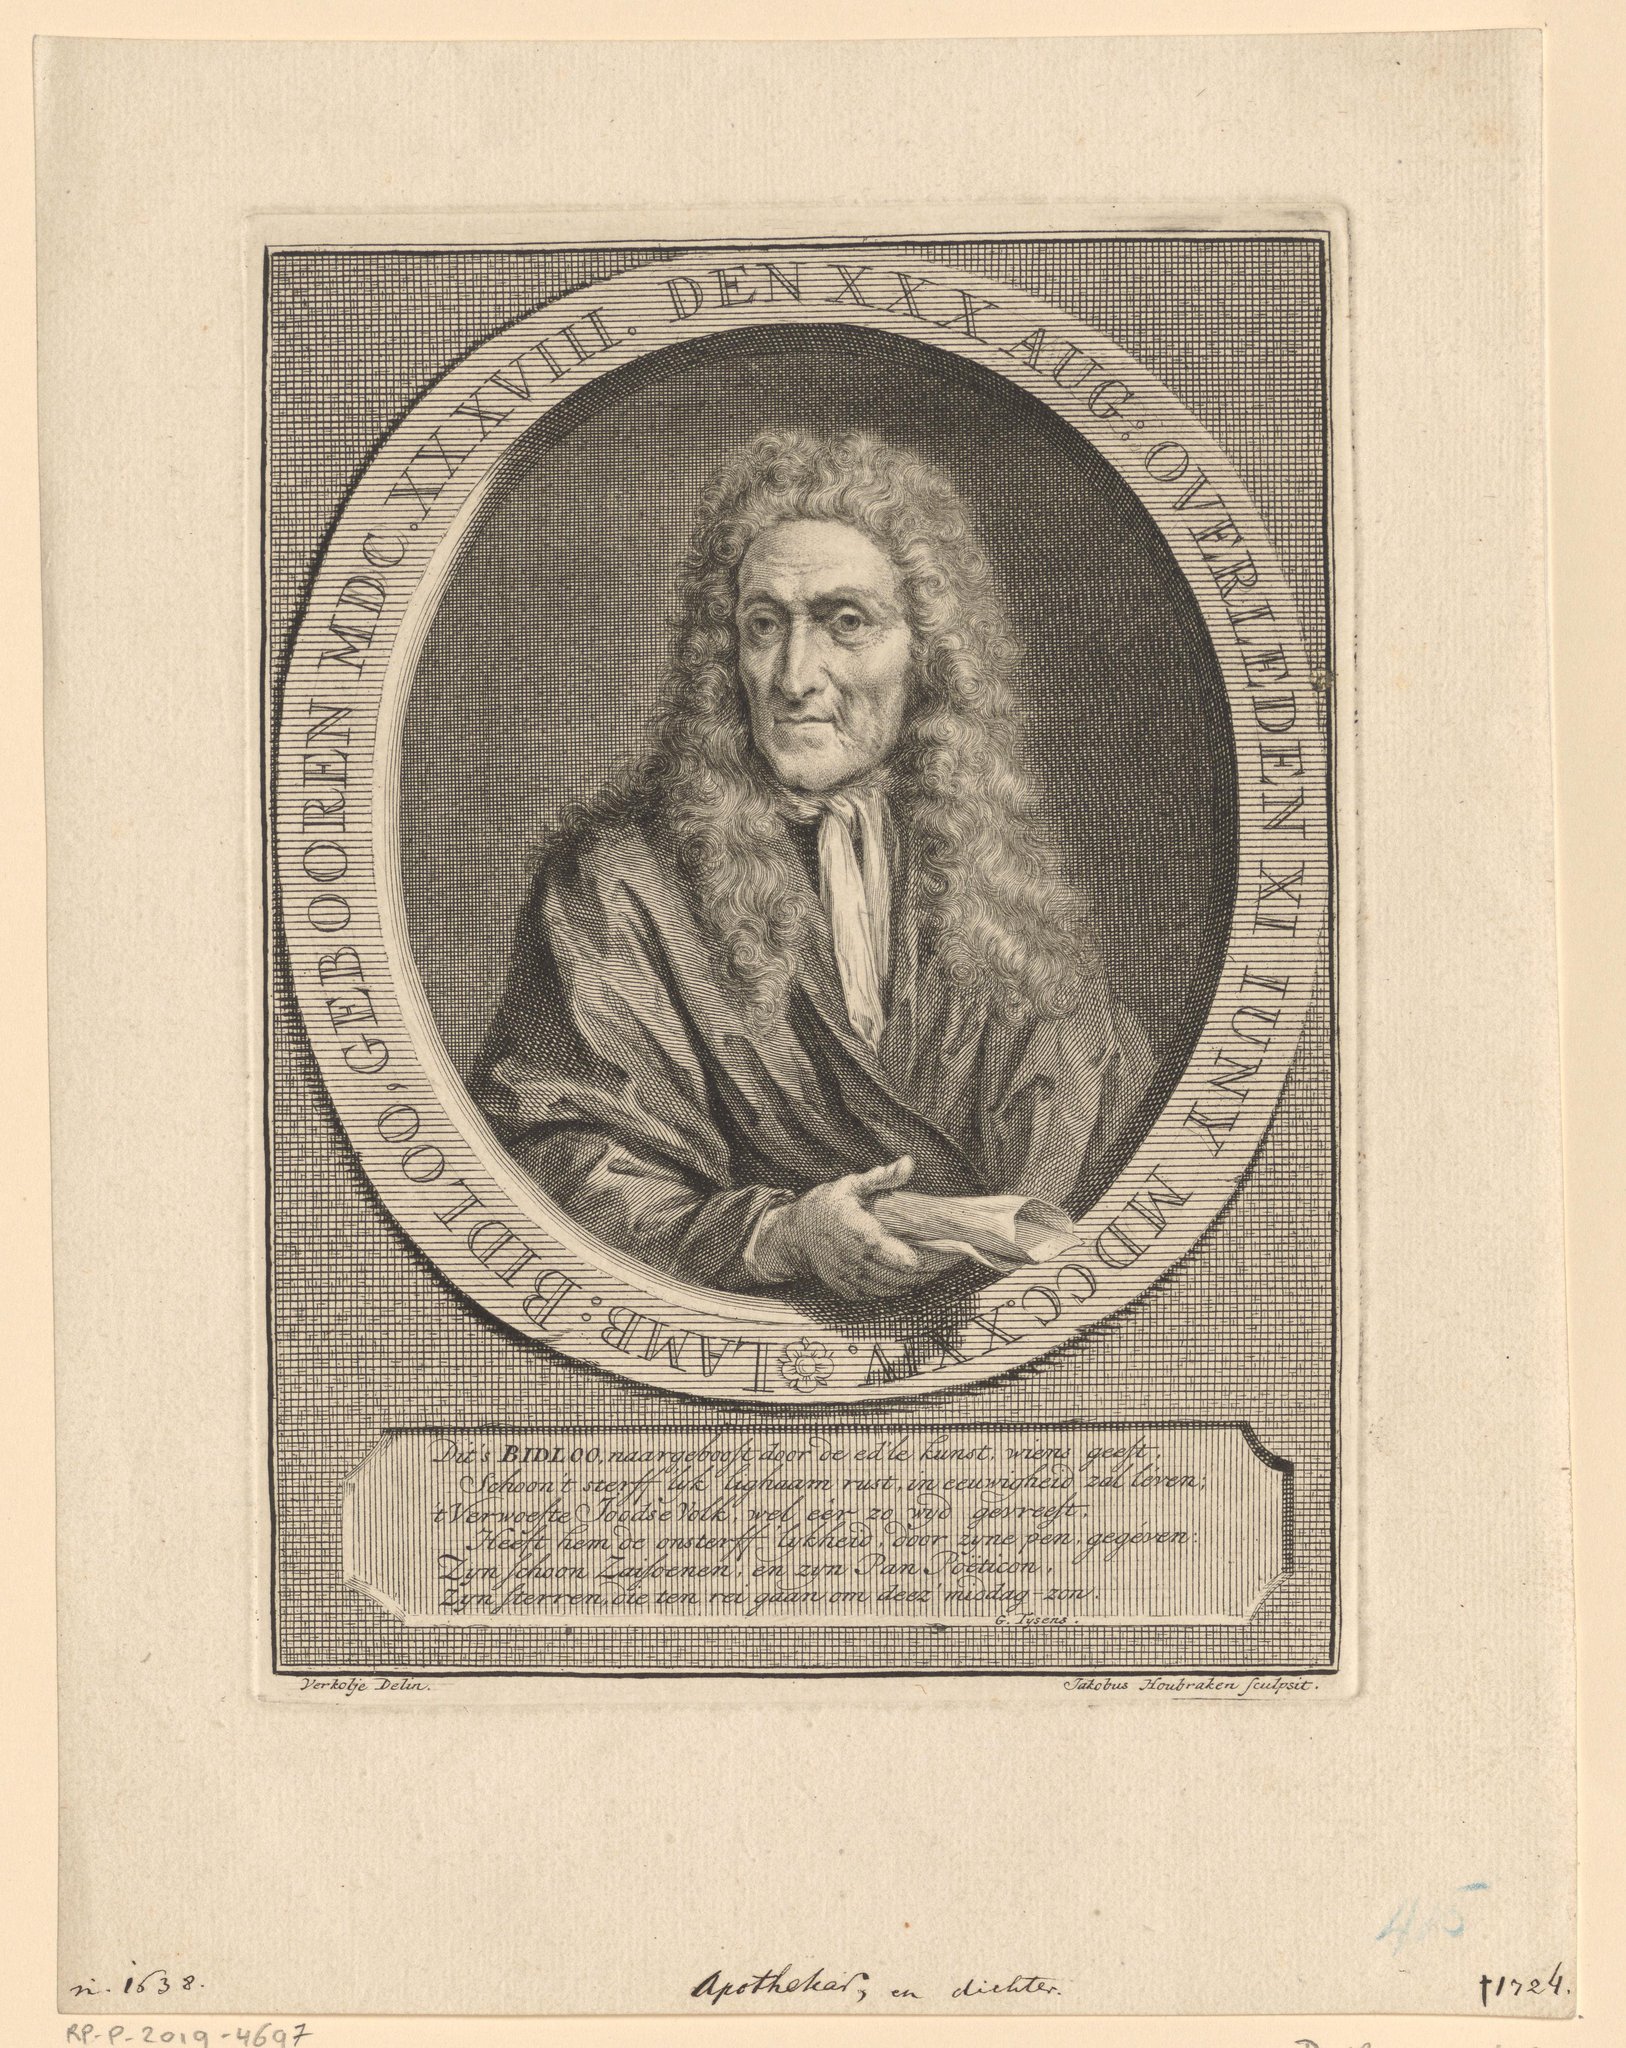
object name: print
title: Portret van Lambert Bidloo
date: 1724-1780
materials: paper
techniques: engraving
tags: amsterdam, lambert bidloo, pharmacist, druggist, apothecary; pharmacy, drugstore, dispensing chemist, historical persons, writer, poet, author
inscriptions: inscription: ‘n. 1632 Apotheker, en dichter. +1724’